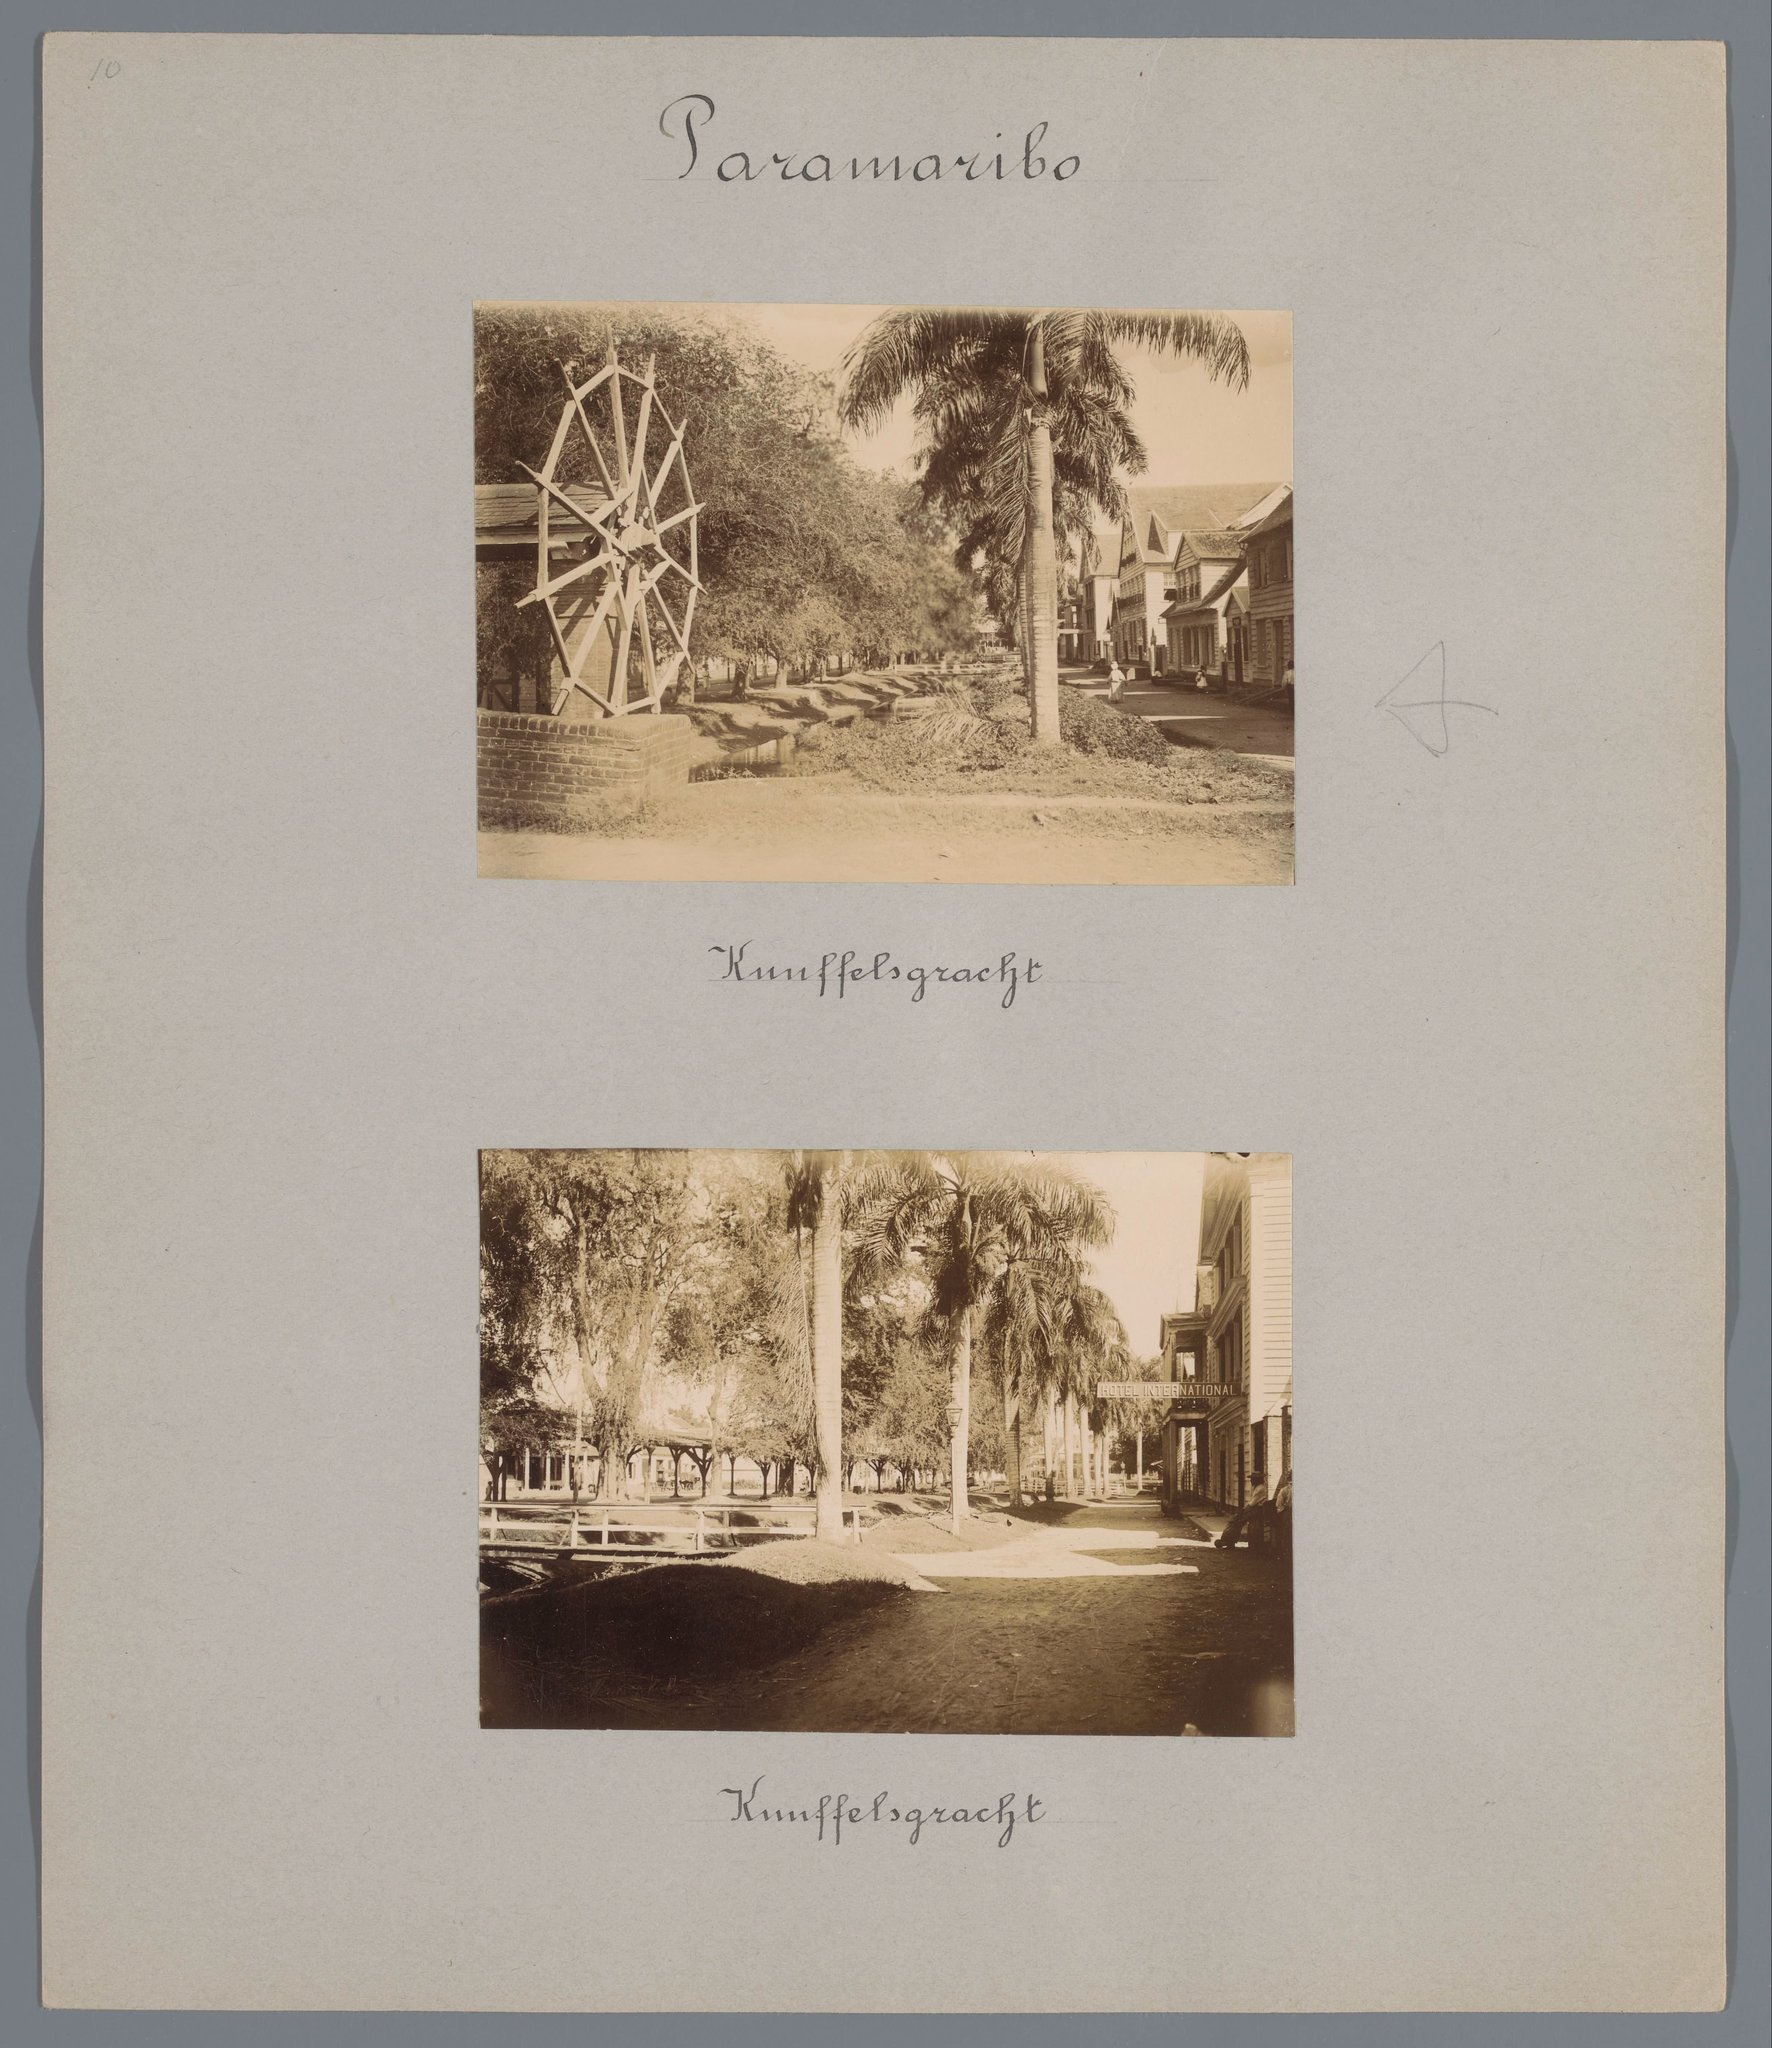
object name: photograph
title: Knuffelsgracht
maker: eugen klein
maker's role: fotograaf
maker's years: 1869-1927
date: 1900-1905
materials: cardboard, photographic support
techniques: gelatin silver print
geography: paramaribo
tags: knuffelsgracht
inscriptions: inscription: ‘Paramaribo / Knuffelsgracht’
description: Gezicht op de sluis aan de Knuffelsgracht te Paramaribo. Onderdeel van een groep van 44 foto's van Paramaribo, Suriname en Curaçao, ca. 1900-1905, opgeplakt op kartons en voorzien van opschriften.